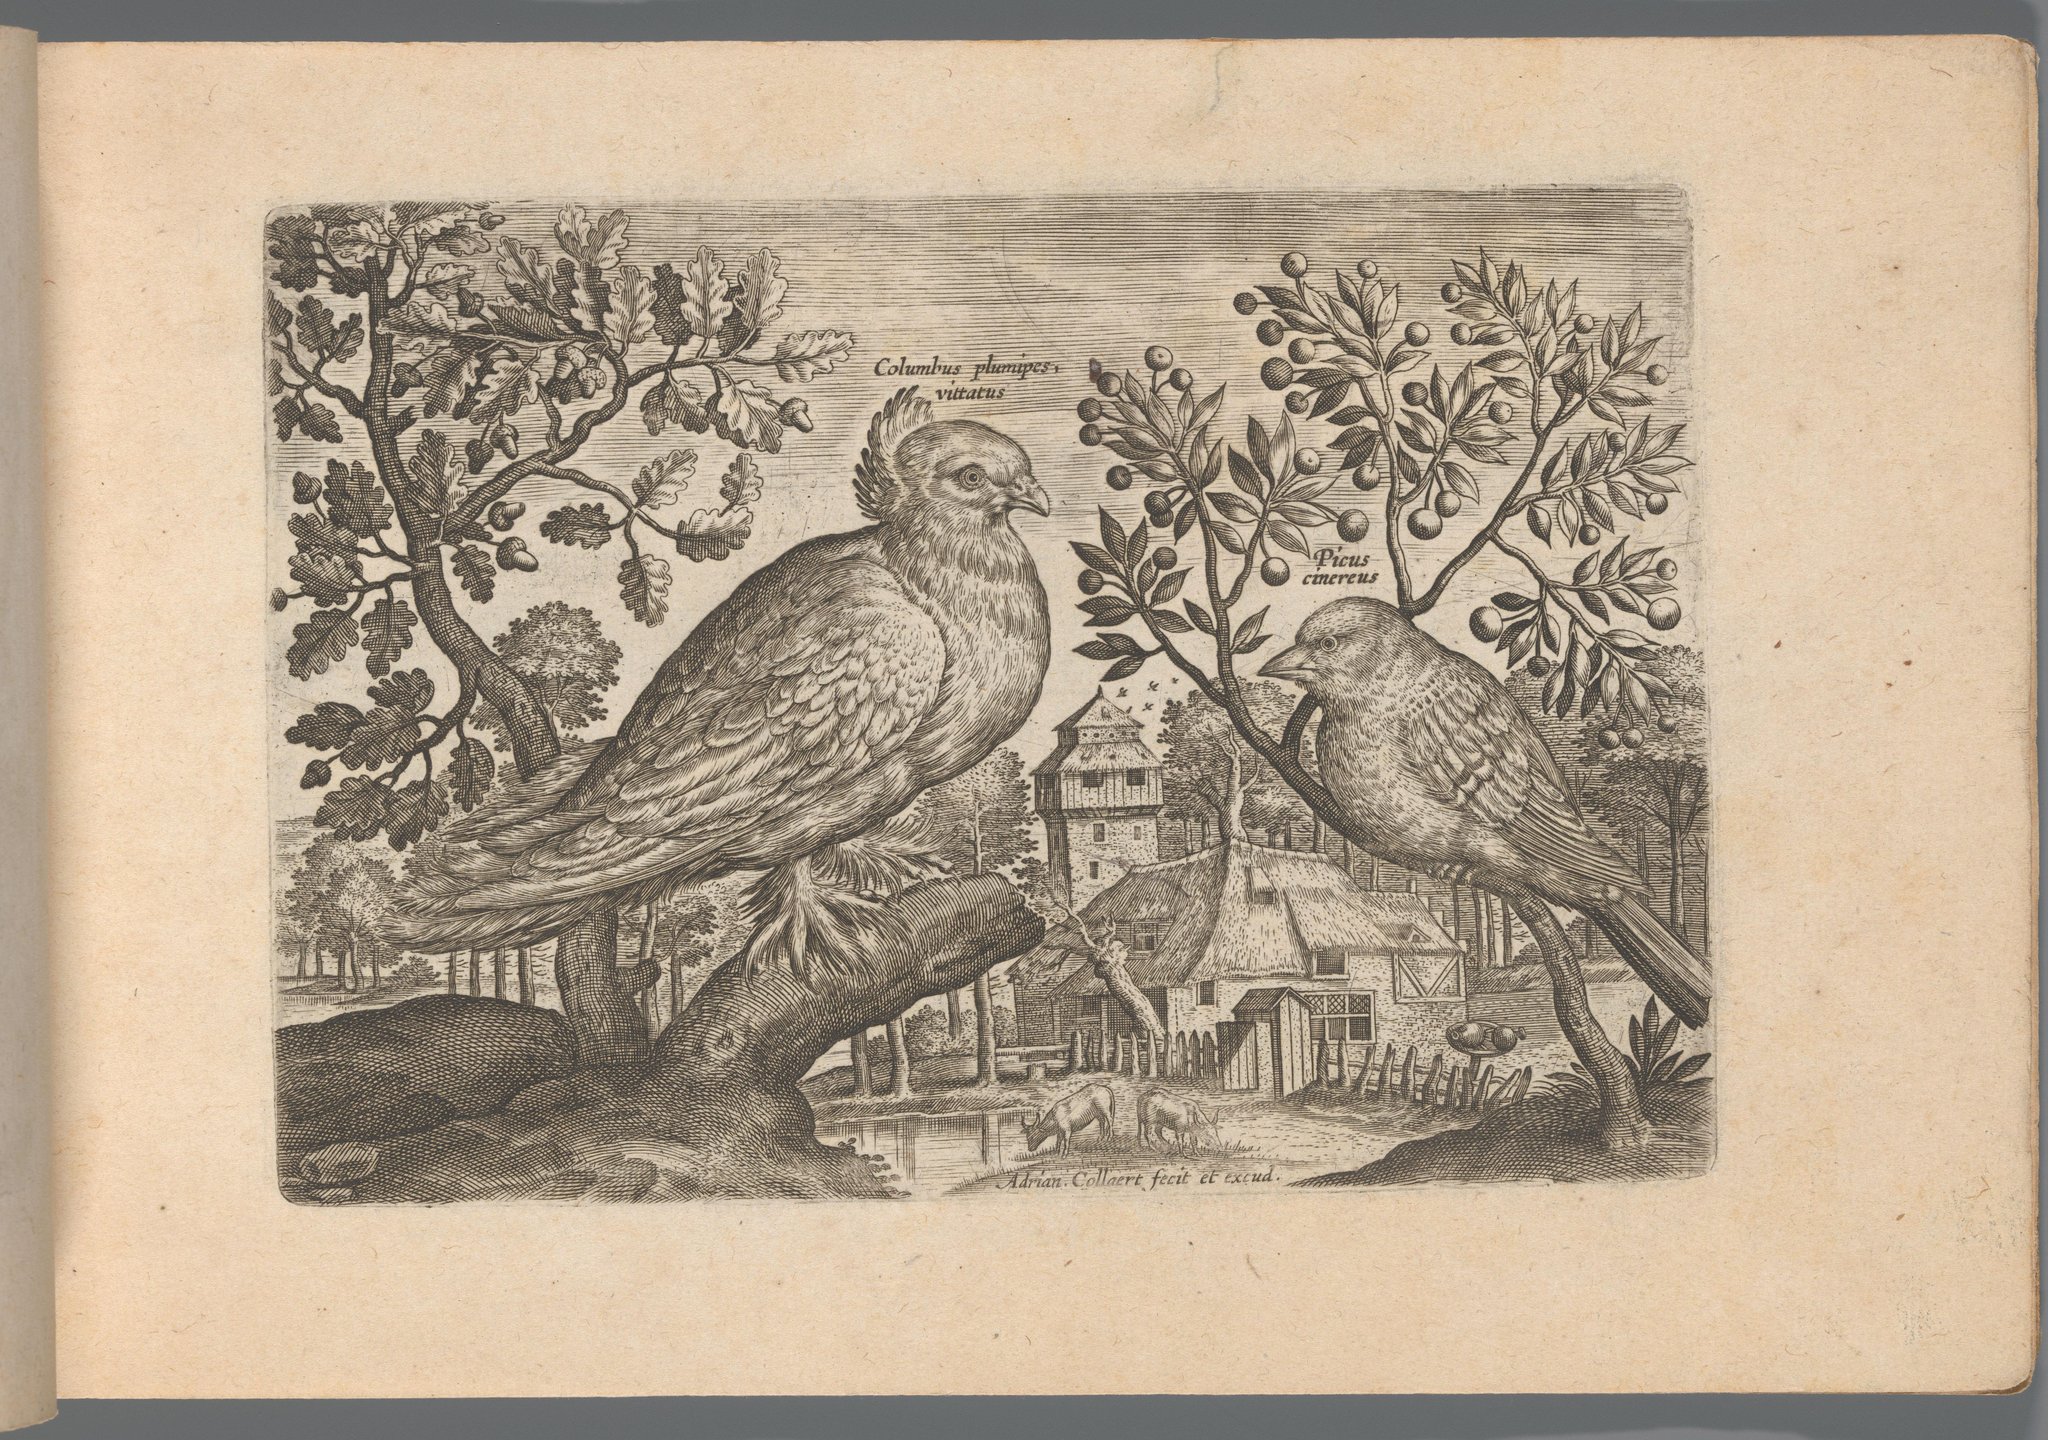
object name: print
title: Columbus plumipes, vittatus / Picus cinereus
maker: adriaen collaert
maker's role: draughtsman, print maker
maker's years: 1560-1618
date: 1570-1600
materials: paper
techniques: engraving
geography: antwerp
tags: song-birds: finch, doves, pigeons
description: Een duif en een vink in een landschap met een hoeve. Prent is onderdeel van een prentalbum met zeven prenten van vogels en de titelprent.